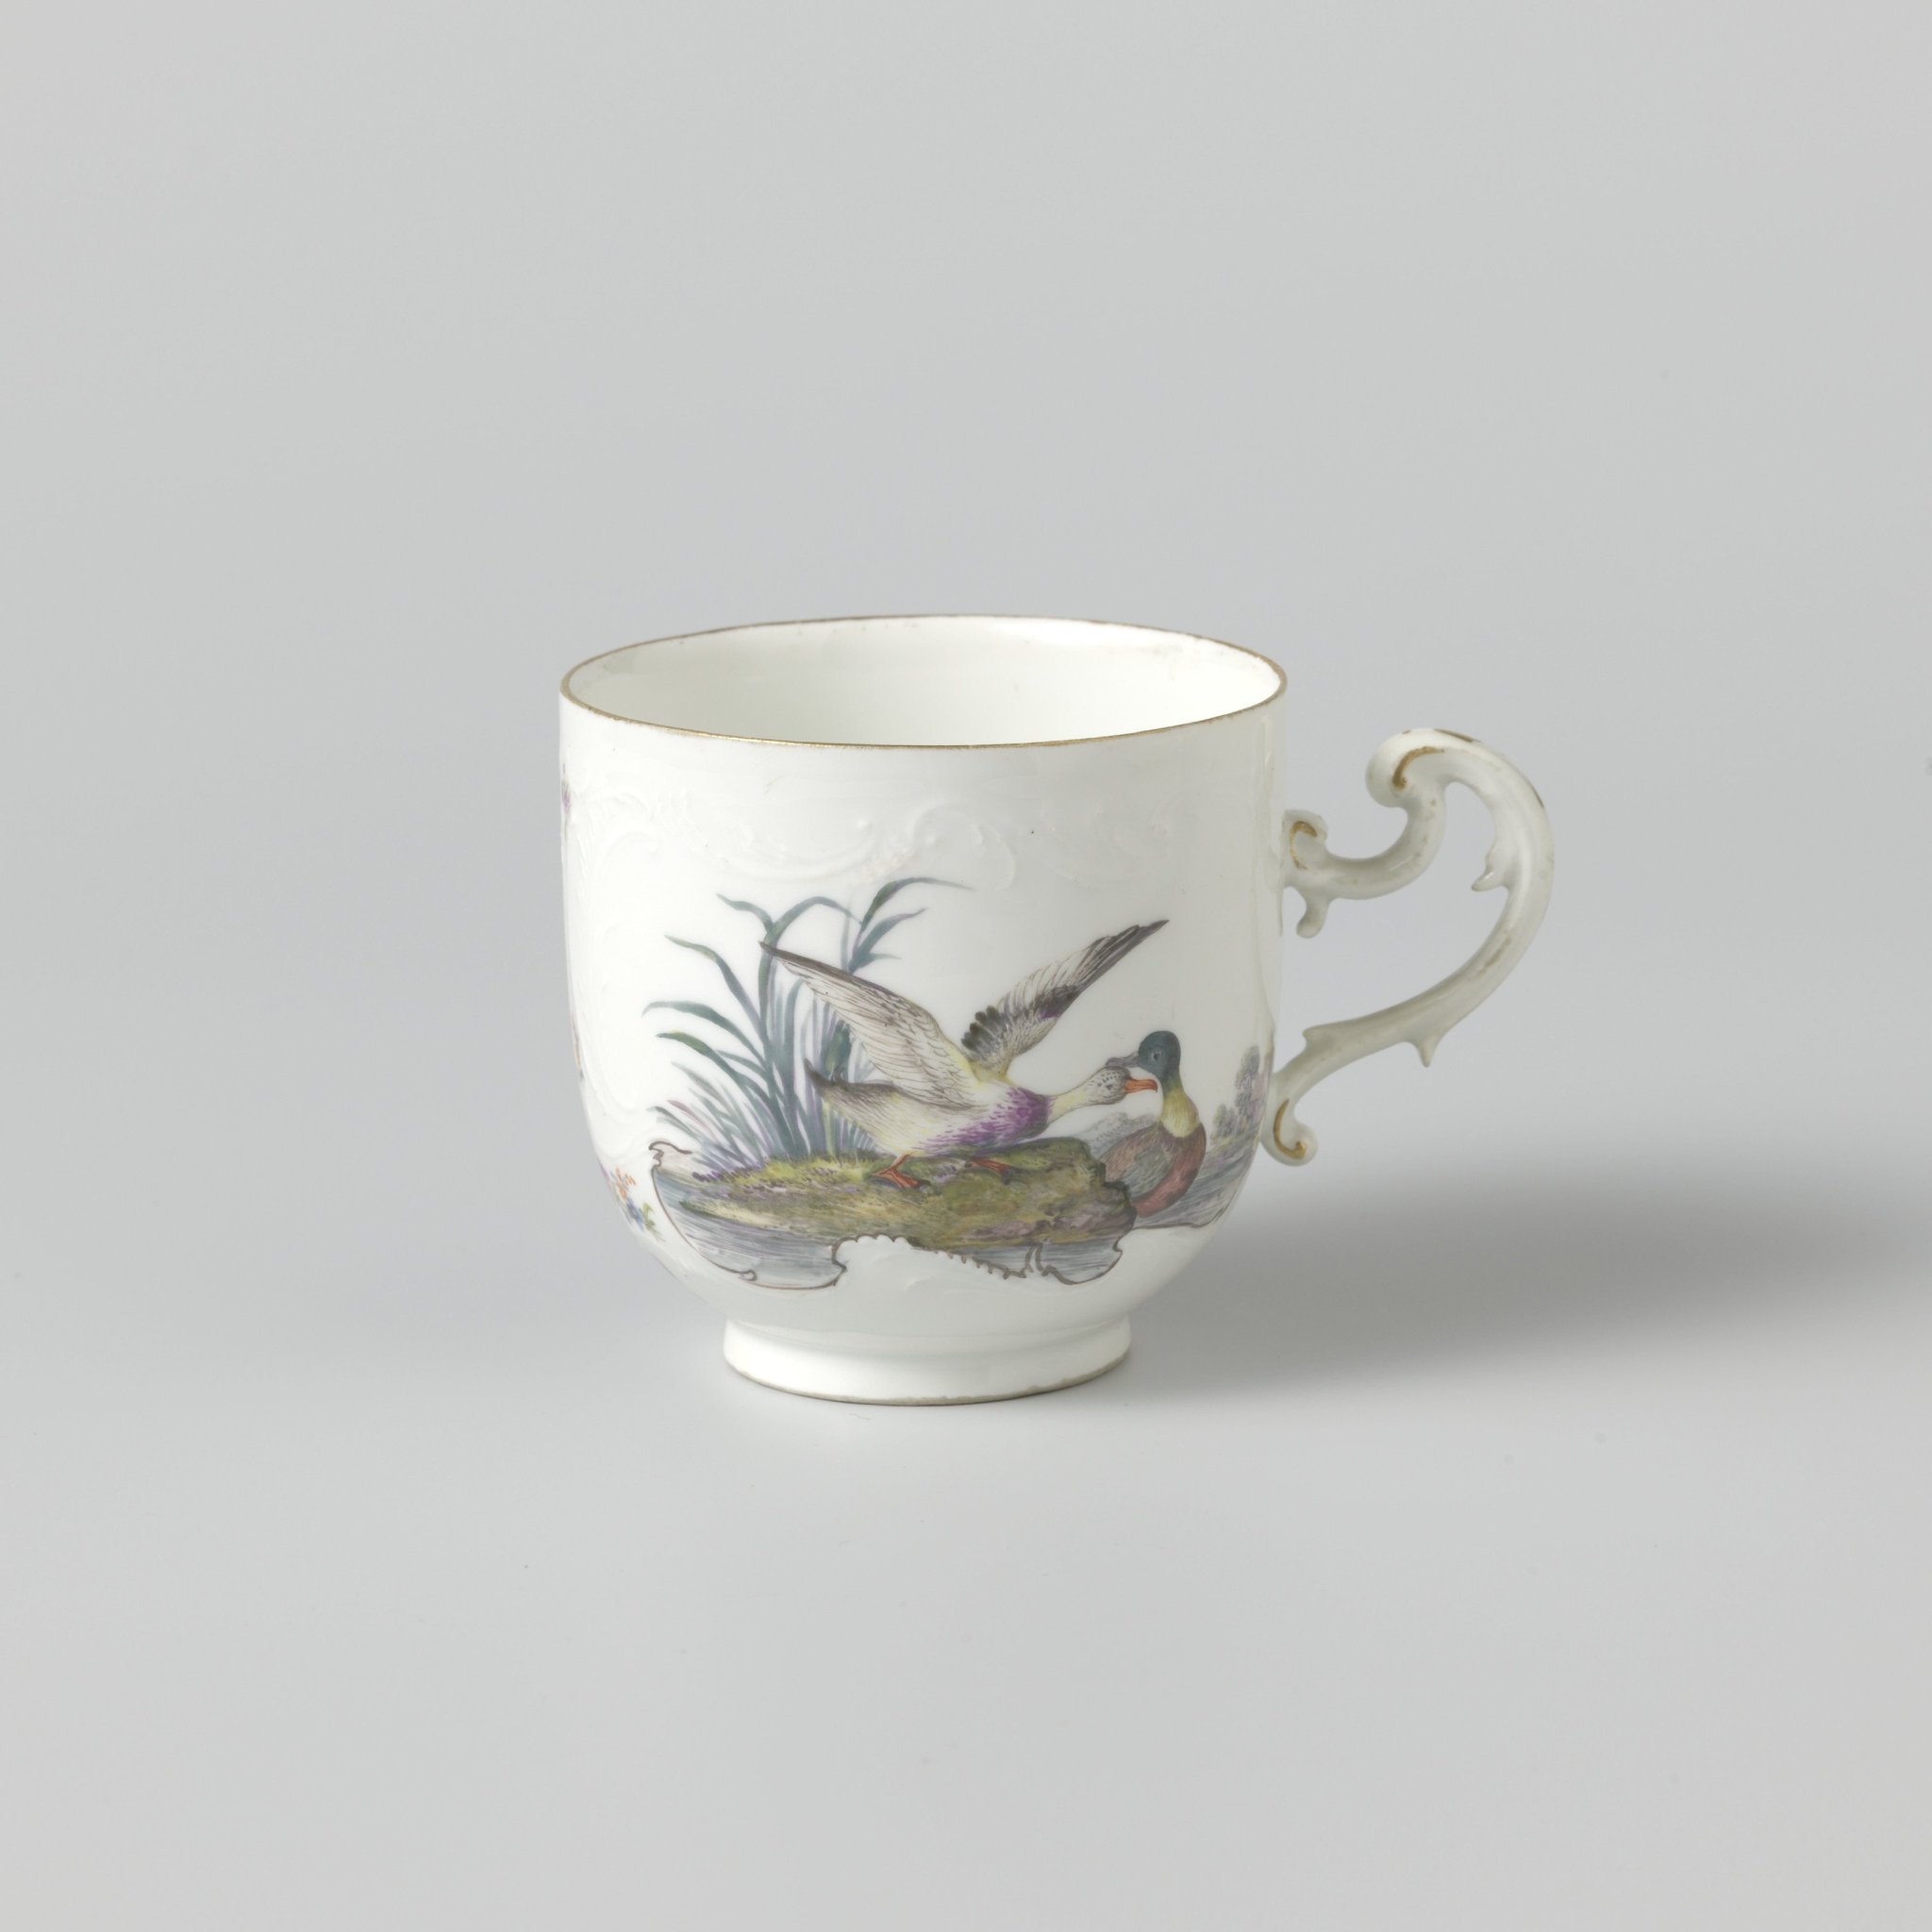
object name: cup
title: Kop, veelkleurig beschilderd met vogels en bloemen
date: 1750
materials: porcelain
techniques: painted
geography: meissen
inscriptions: factory mark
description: Halfbolvormige kop van beschilderd porselein. De kop heeft een rijk versierd dubbel gebogen oor. De kop is binnen rocaille-cartouches in reliëf veelkleurig beschilderd met bloemen en vogels op een grond. De kop is gemerkt.